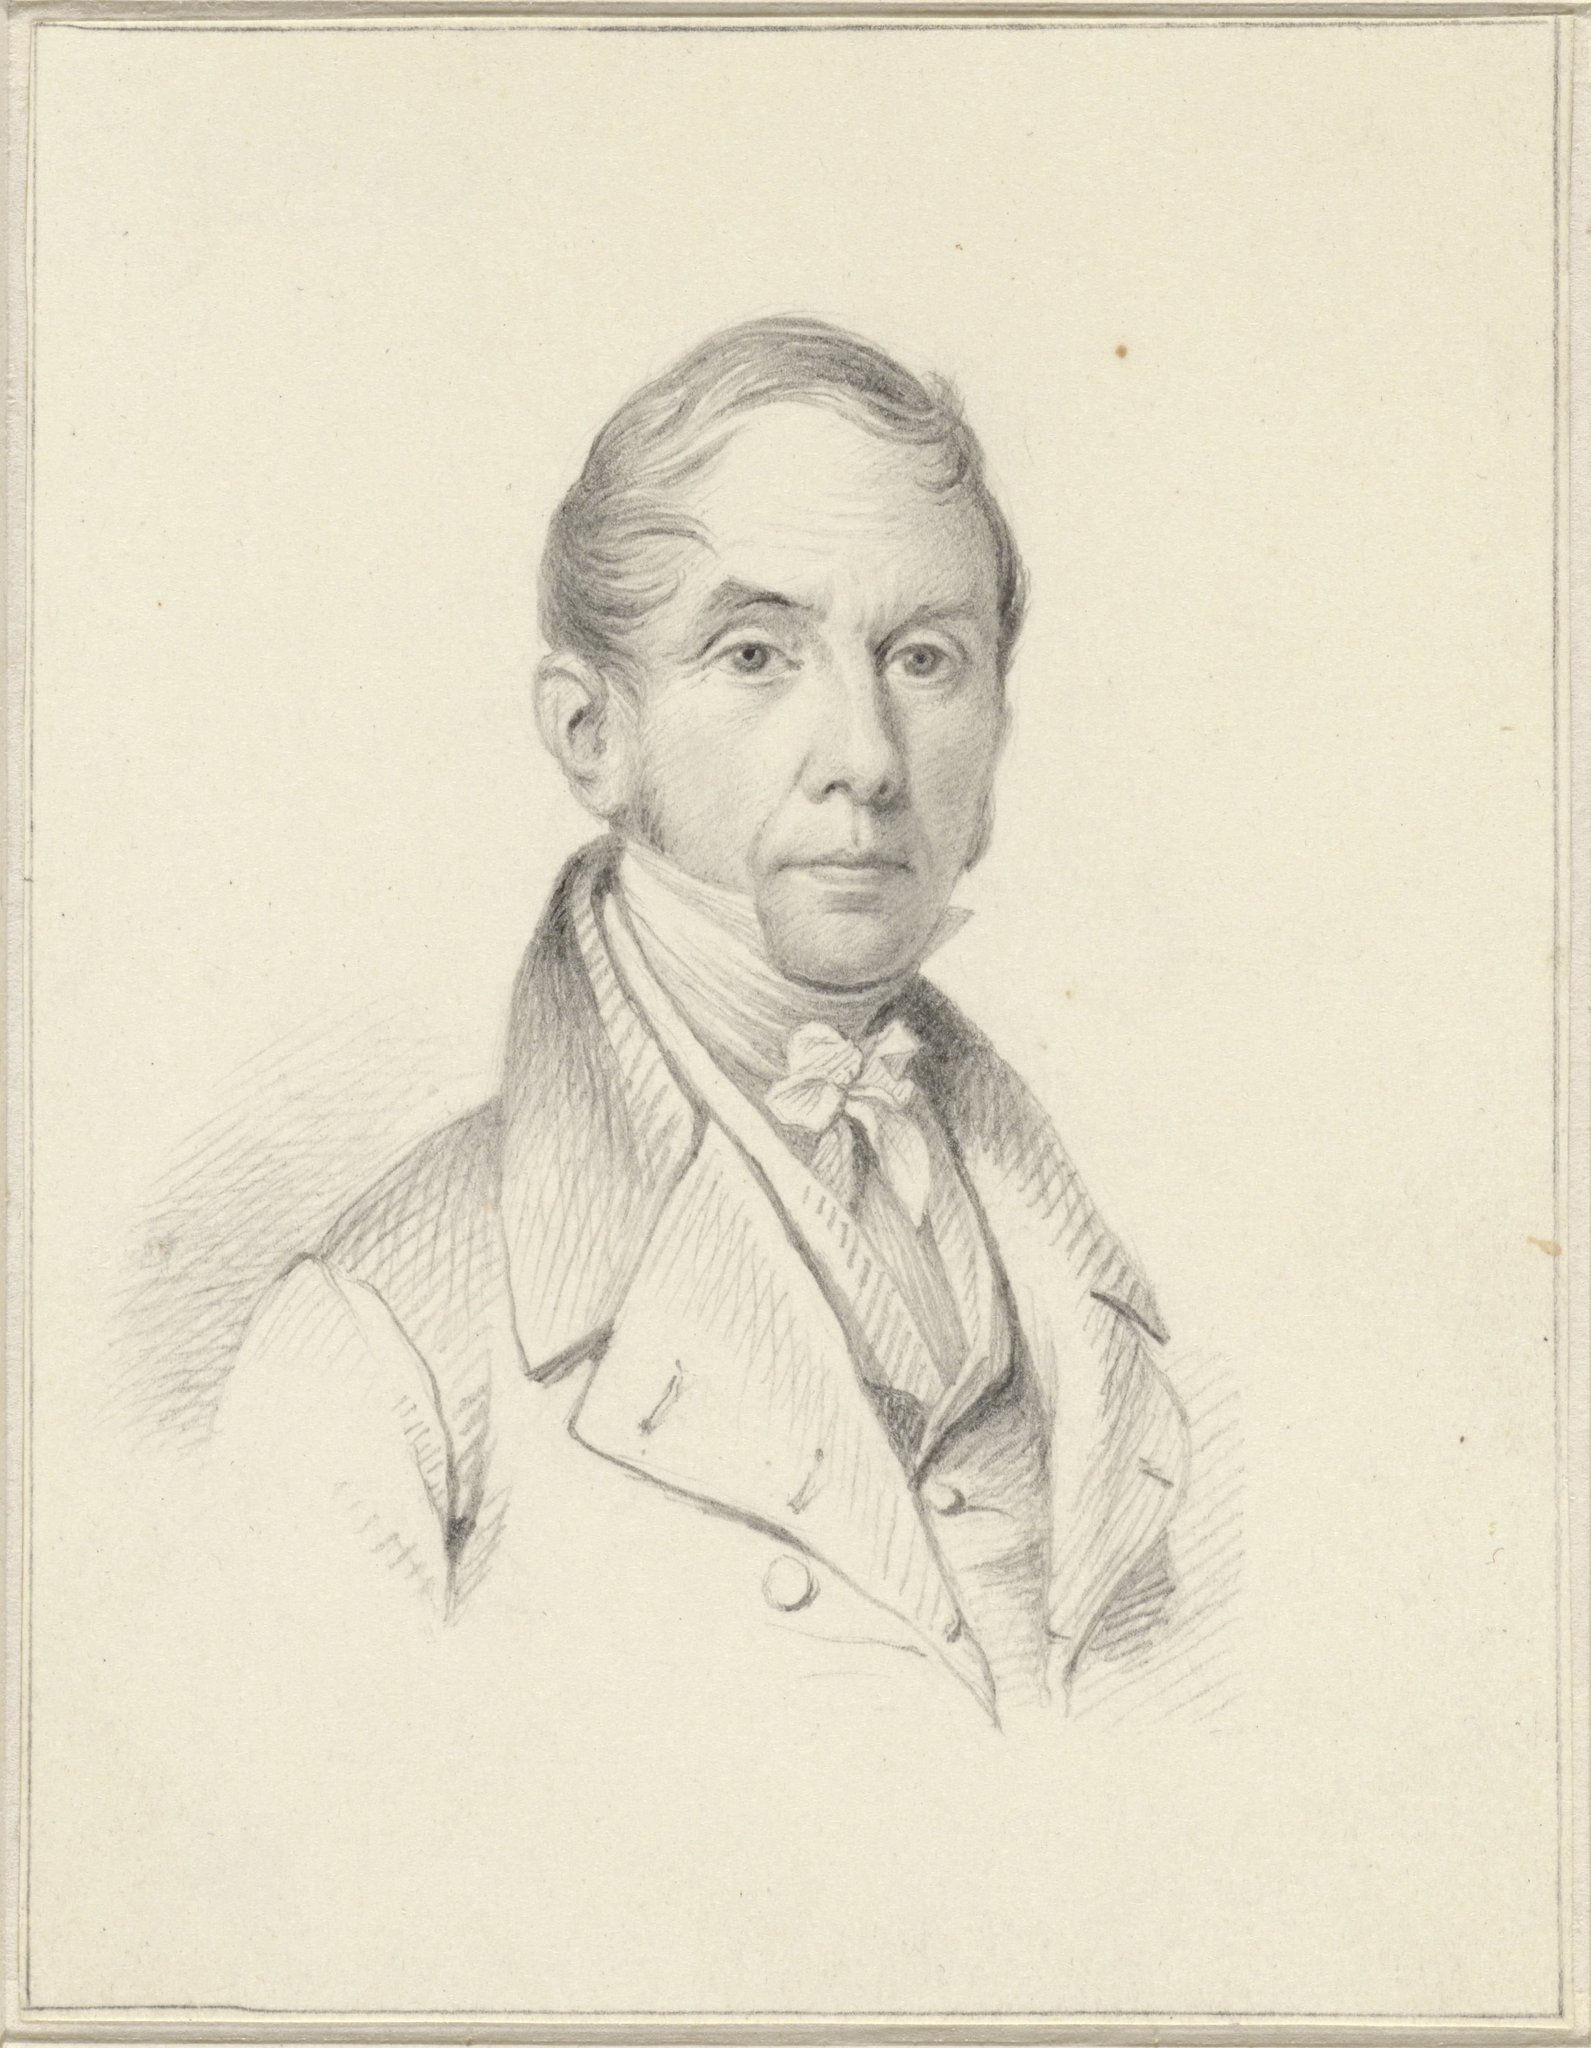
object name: drawing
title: Zelfportret van Johannes Hari I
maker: johannes hari (i)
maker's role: draughtsman, painter, print maker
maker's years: 1772-1849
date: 1800-1849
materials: paper, pencil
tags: the hague, painter, print maker, draughtsman, johannes hari (i), historical persons, portrait, self-portrait of painter, portrait, self-portrait of artist, portrait, self-portrait of draughtsman